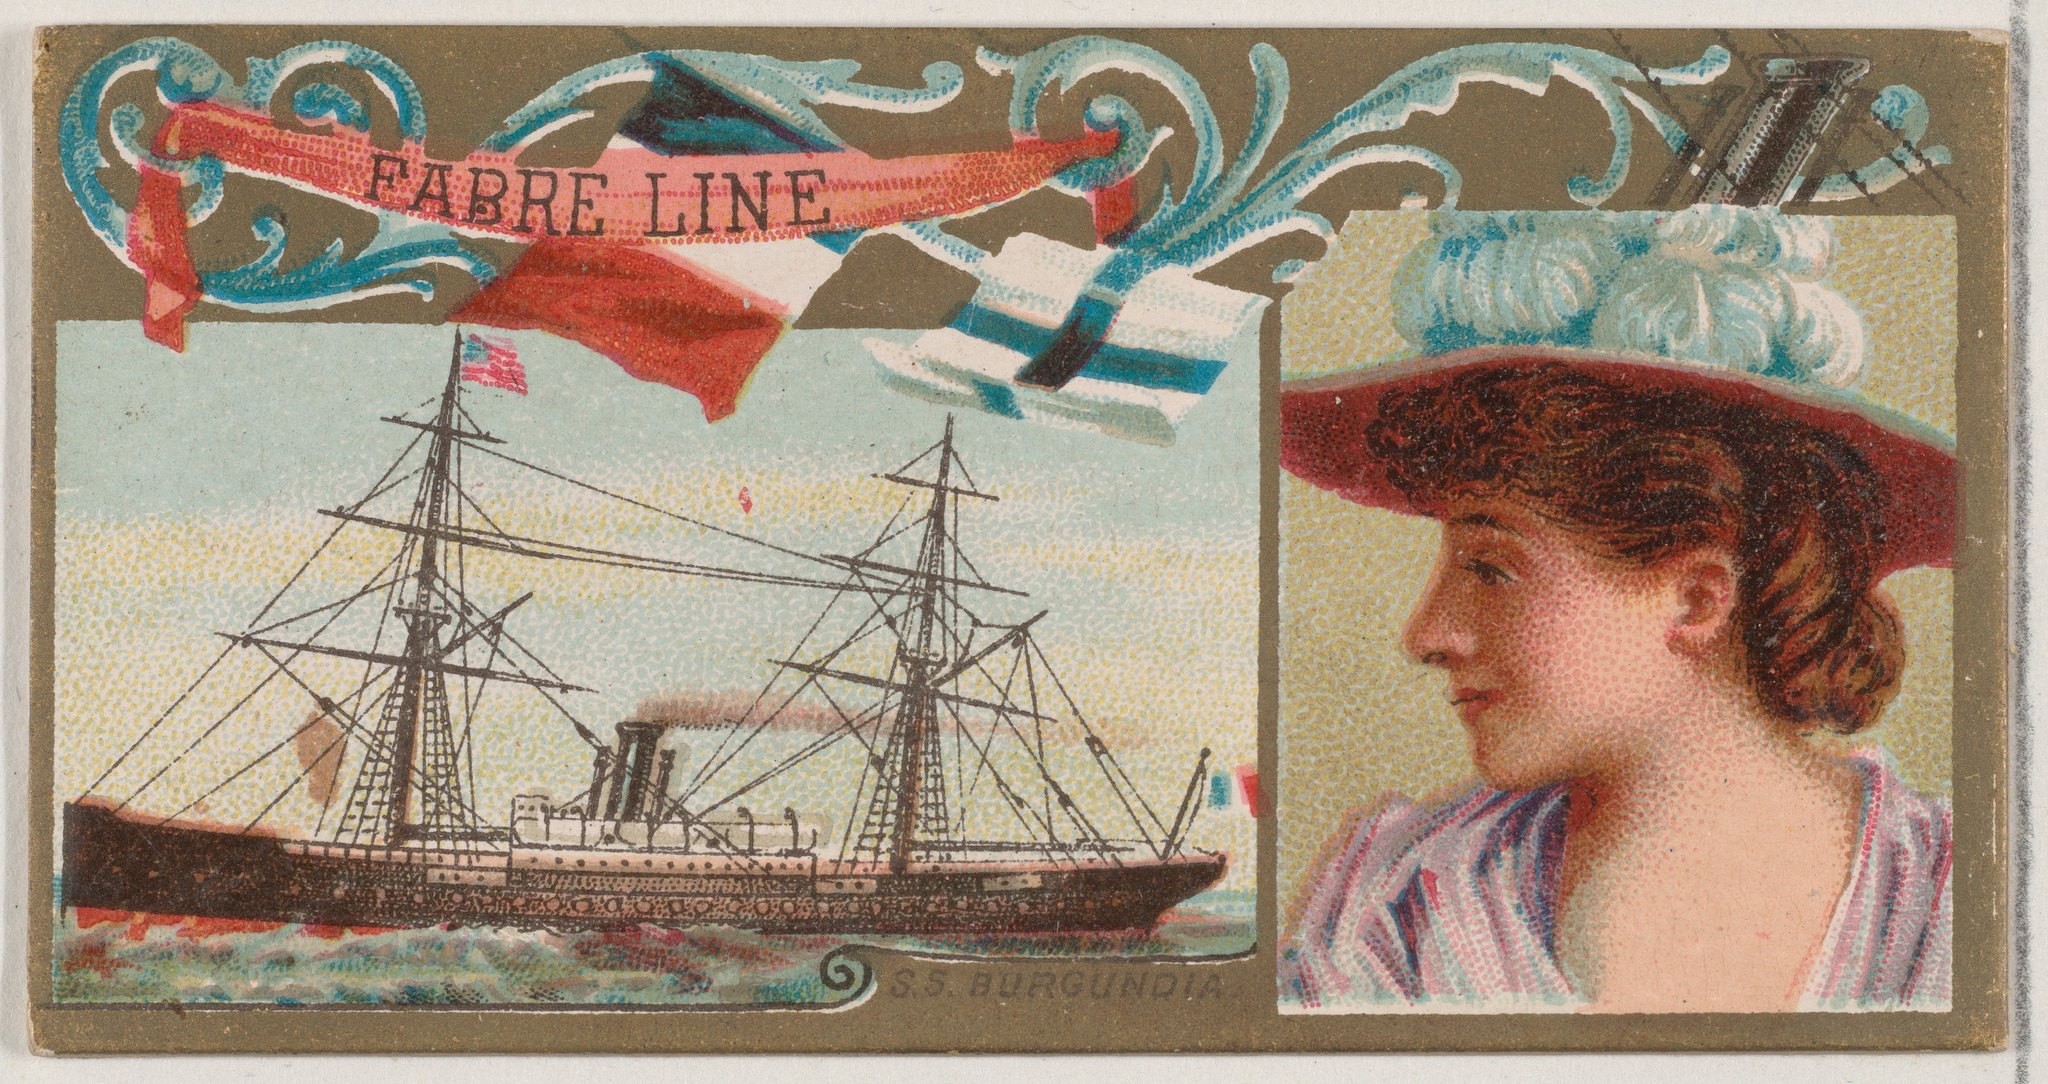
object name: print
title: Steamship Burgundia, Fabre Line, from the Ocean and River Steamers series (N83) for Duke brand cigarettes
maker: w. duke, sons & co.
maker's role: publisher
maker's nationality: american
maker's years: 1870-1920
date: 1887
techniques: color lithograph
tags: women,ships